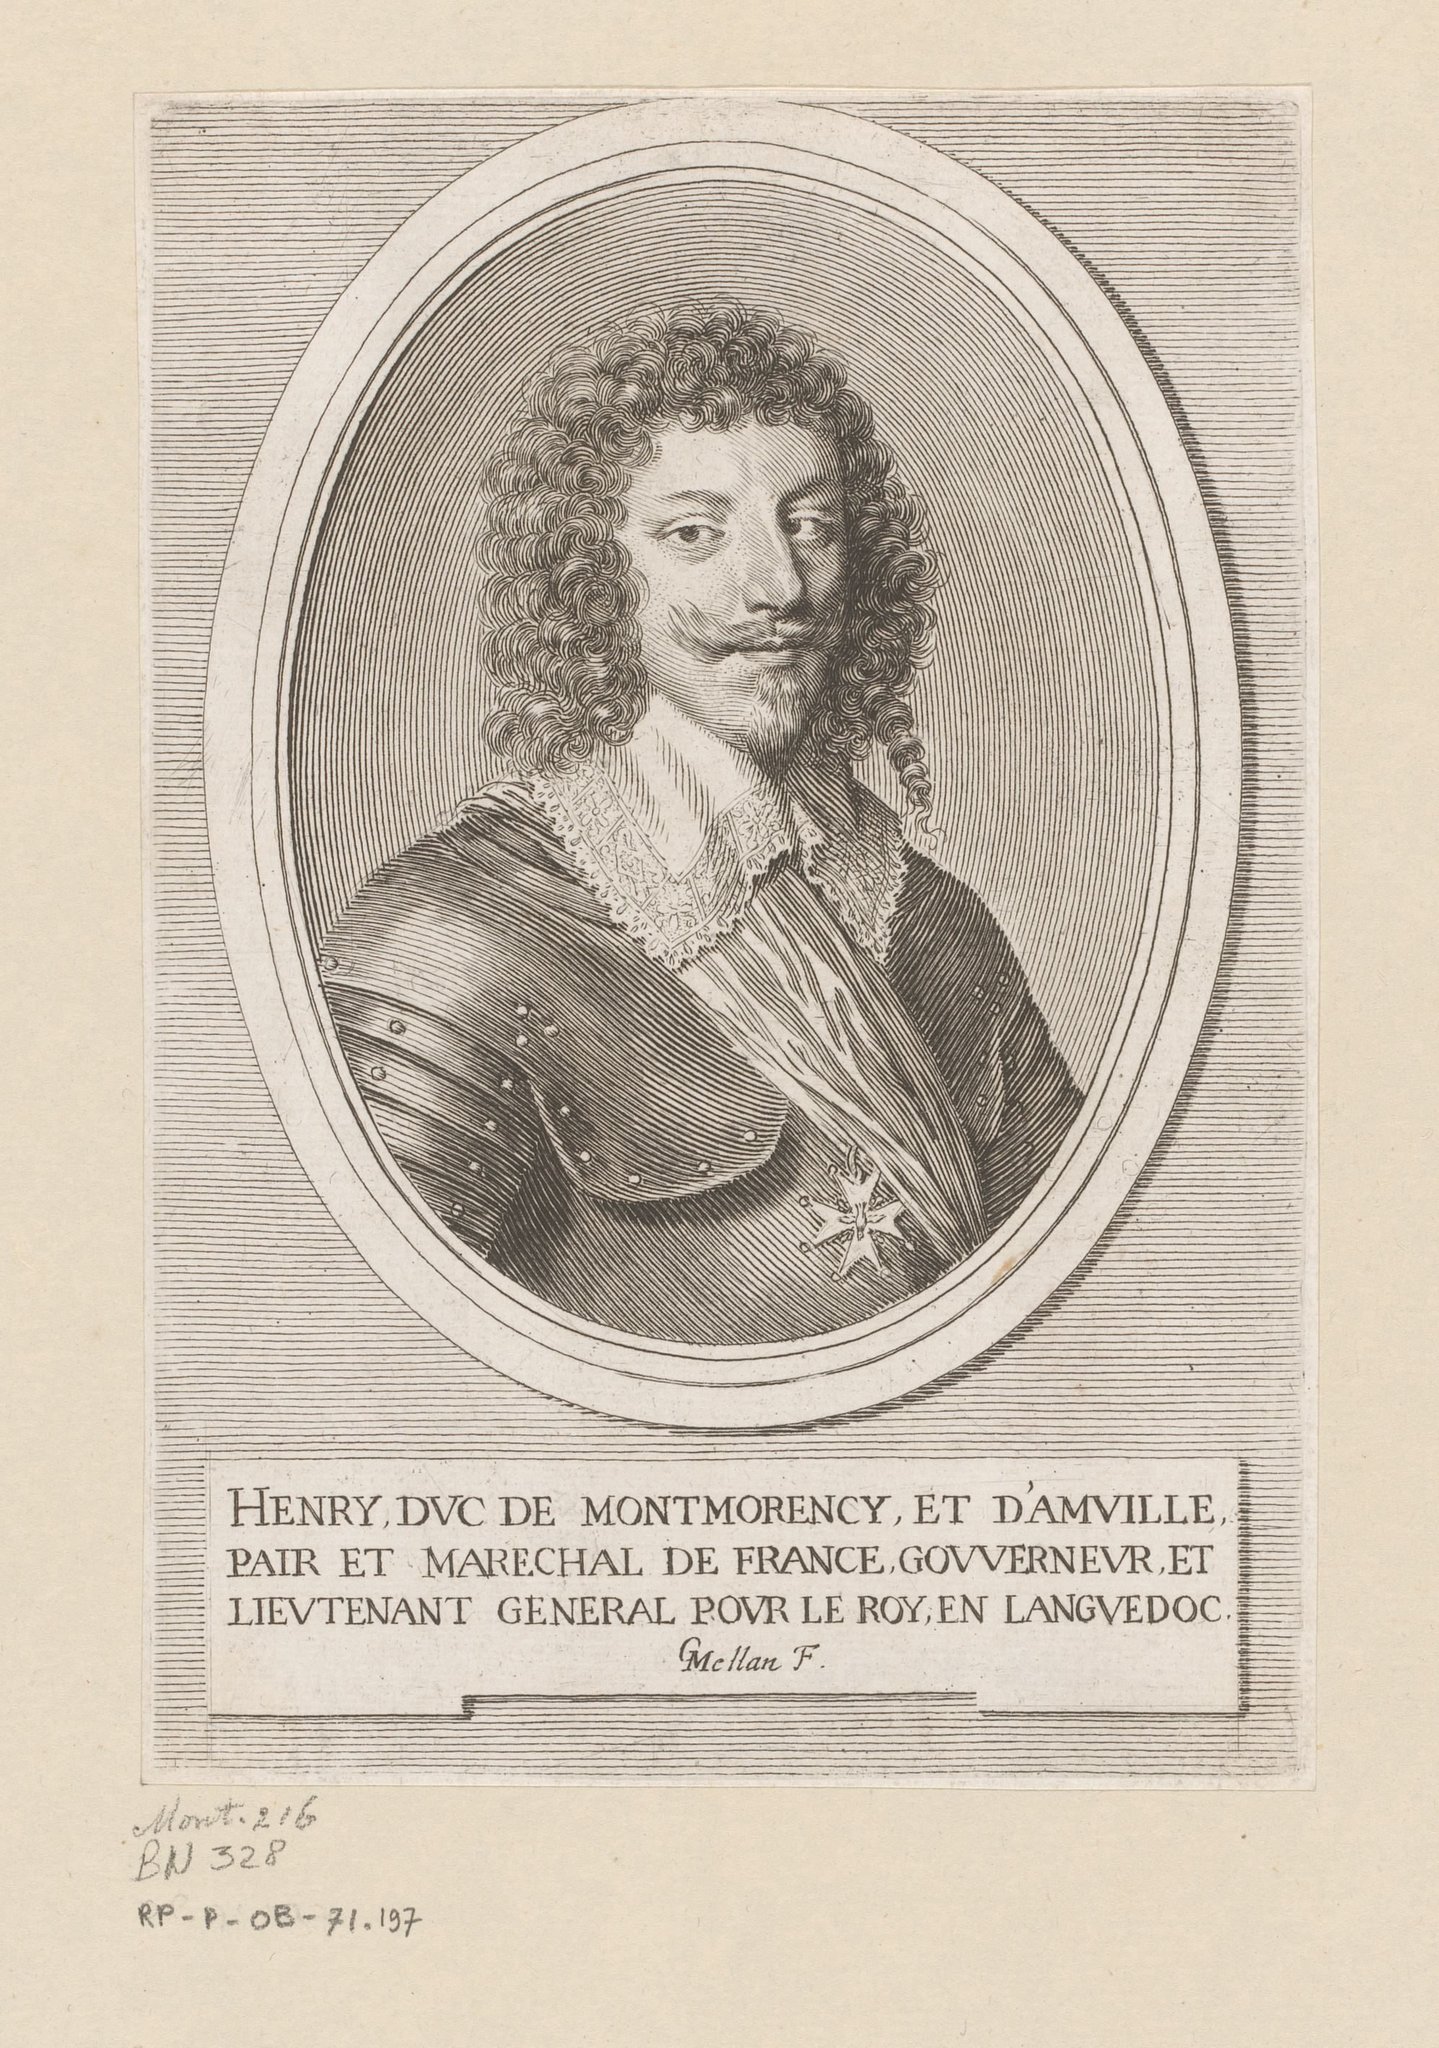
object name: book illustration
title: Portret van Henri II, duc de Montmorency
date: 1643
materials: paper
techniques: engraving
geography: france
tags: chantilly, historical persons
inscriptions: inscription: ‘P. Mariette 1674’, collector's mark: Lugt 240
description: Prent uit: Du Cros, Simon. Histoire de la vie de Henri, dernier duc de Montmorency. Parijs: Antoine de Sommaville en Augustin Courbé, 1643.